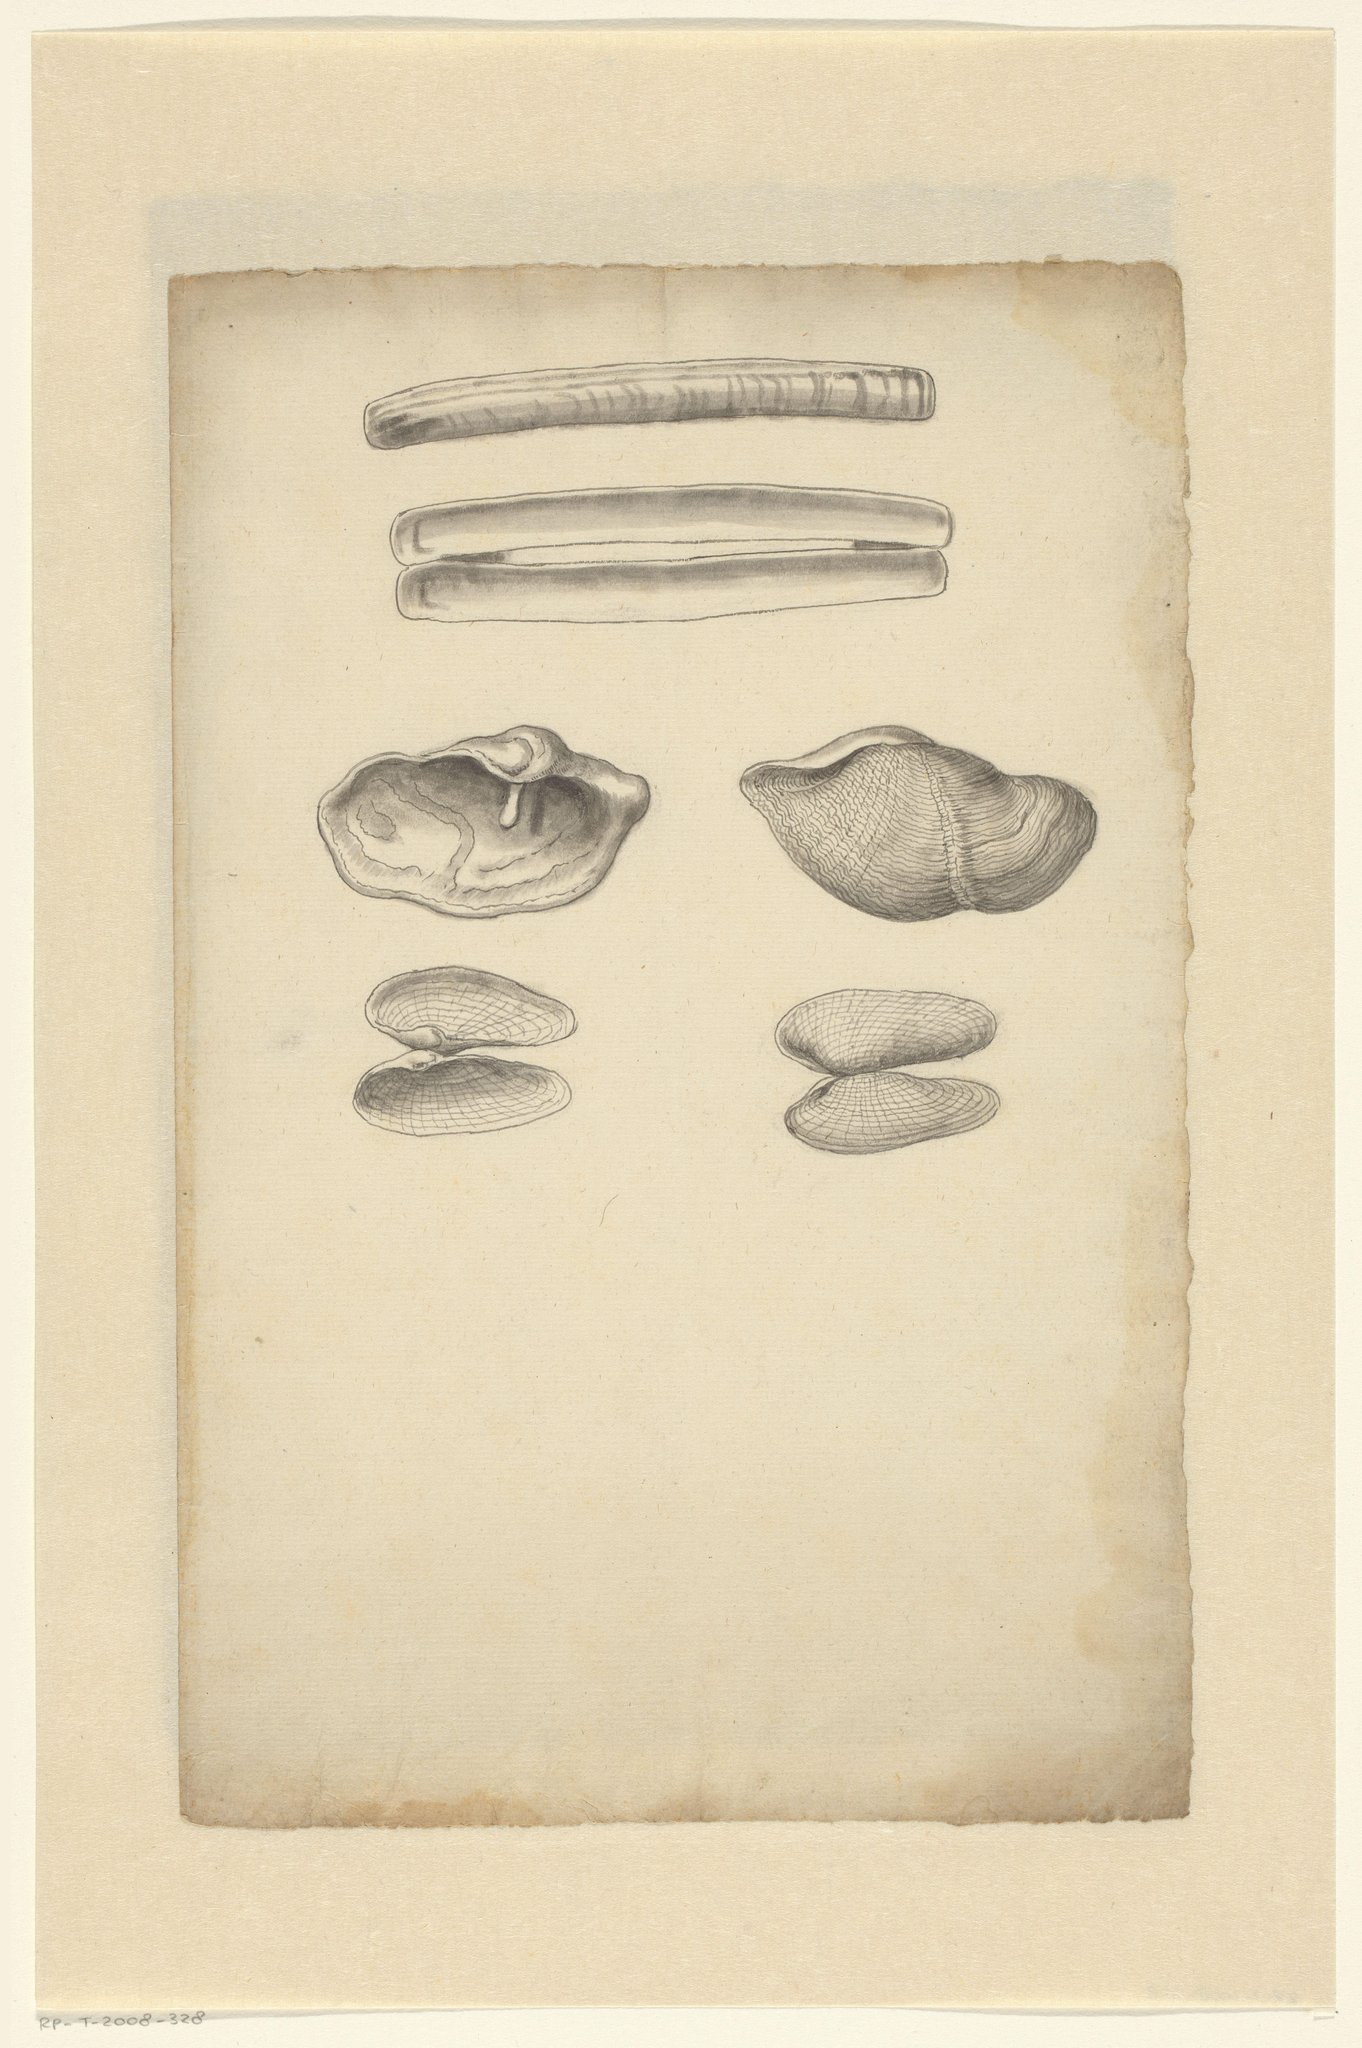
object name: drawing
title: Study sheet with razor shells (Ensis arcuatus), stone-borers (Zirfaea Crispata), and white mussels (Barnea Candida)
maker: Anonymous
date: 1575-1599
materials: ink, paper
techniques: brush, pen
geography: netherlands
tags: molluscs: mussel